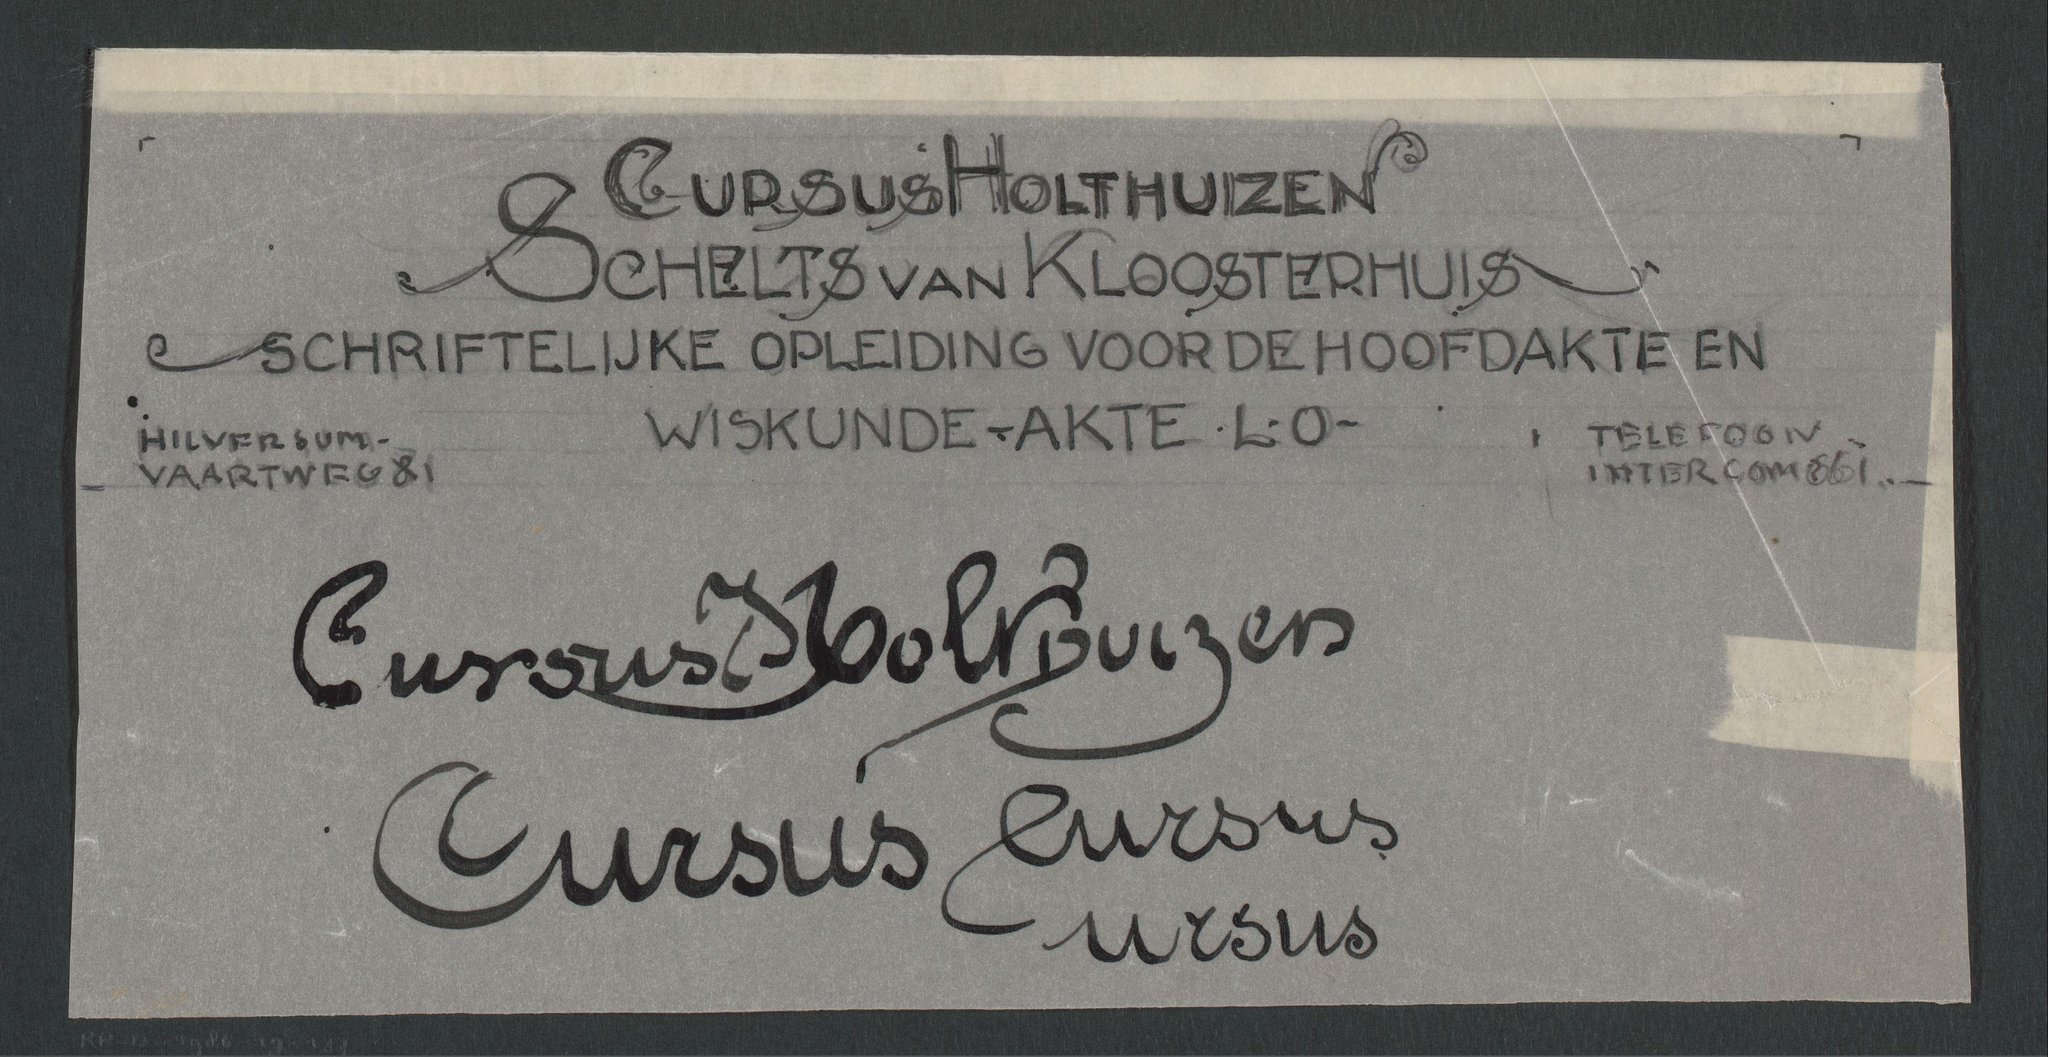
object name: drawing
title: Ontwerp voor een briefhoofd van Cursus Holthuizen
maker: reinier willem petrus de vries (1874-1953)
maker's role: draughtsman, print maker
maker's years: 1874-1953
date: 1884-1952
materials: ink, pencil, paper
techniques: brush, pen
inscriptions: collector's mark: ‘R:MVS.’